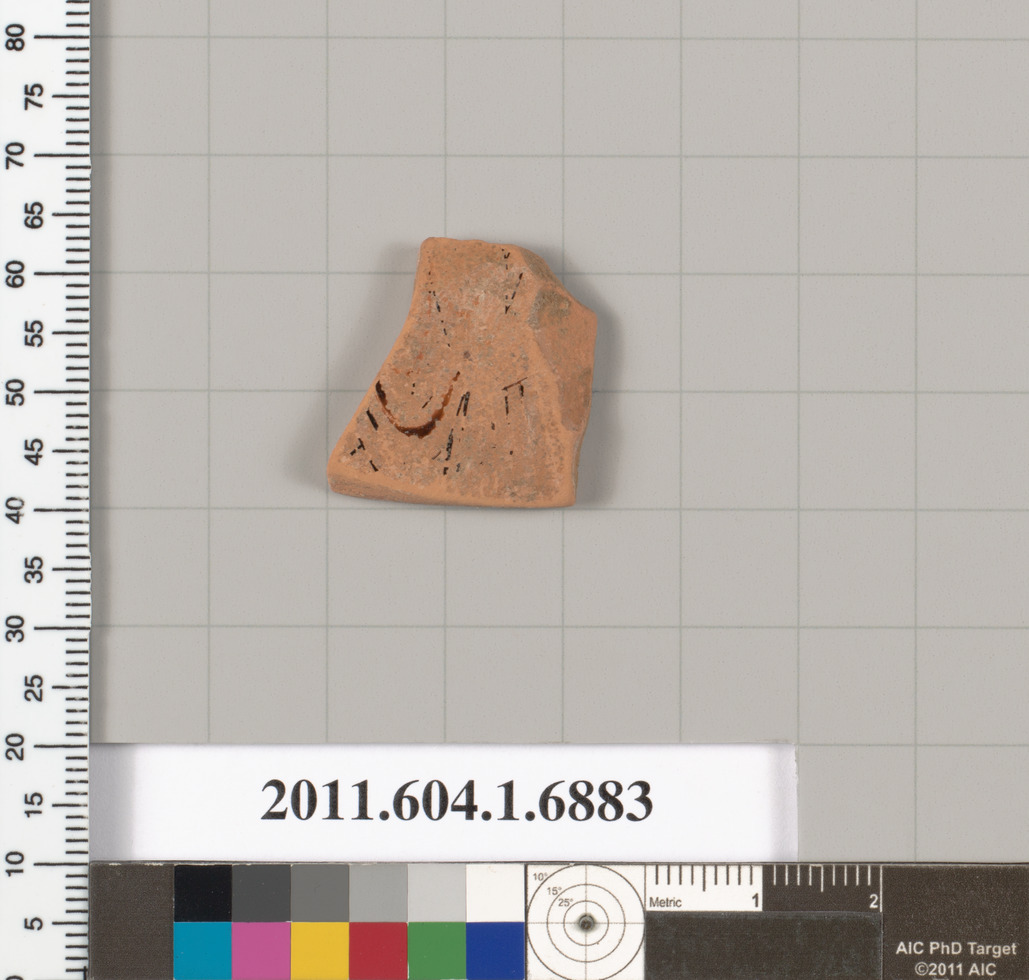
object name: kylix fragment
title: Terracotta fragment of a kylix (drinking cup)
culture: greek, attic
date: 490-470 BCE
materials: terracotta